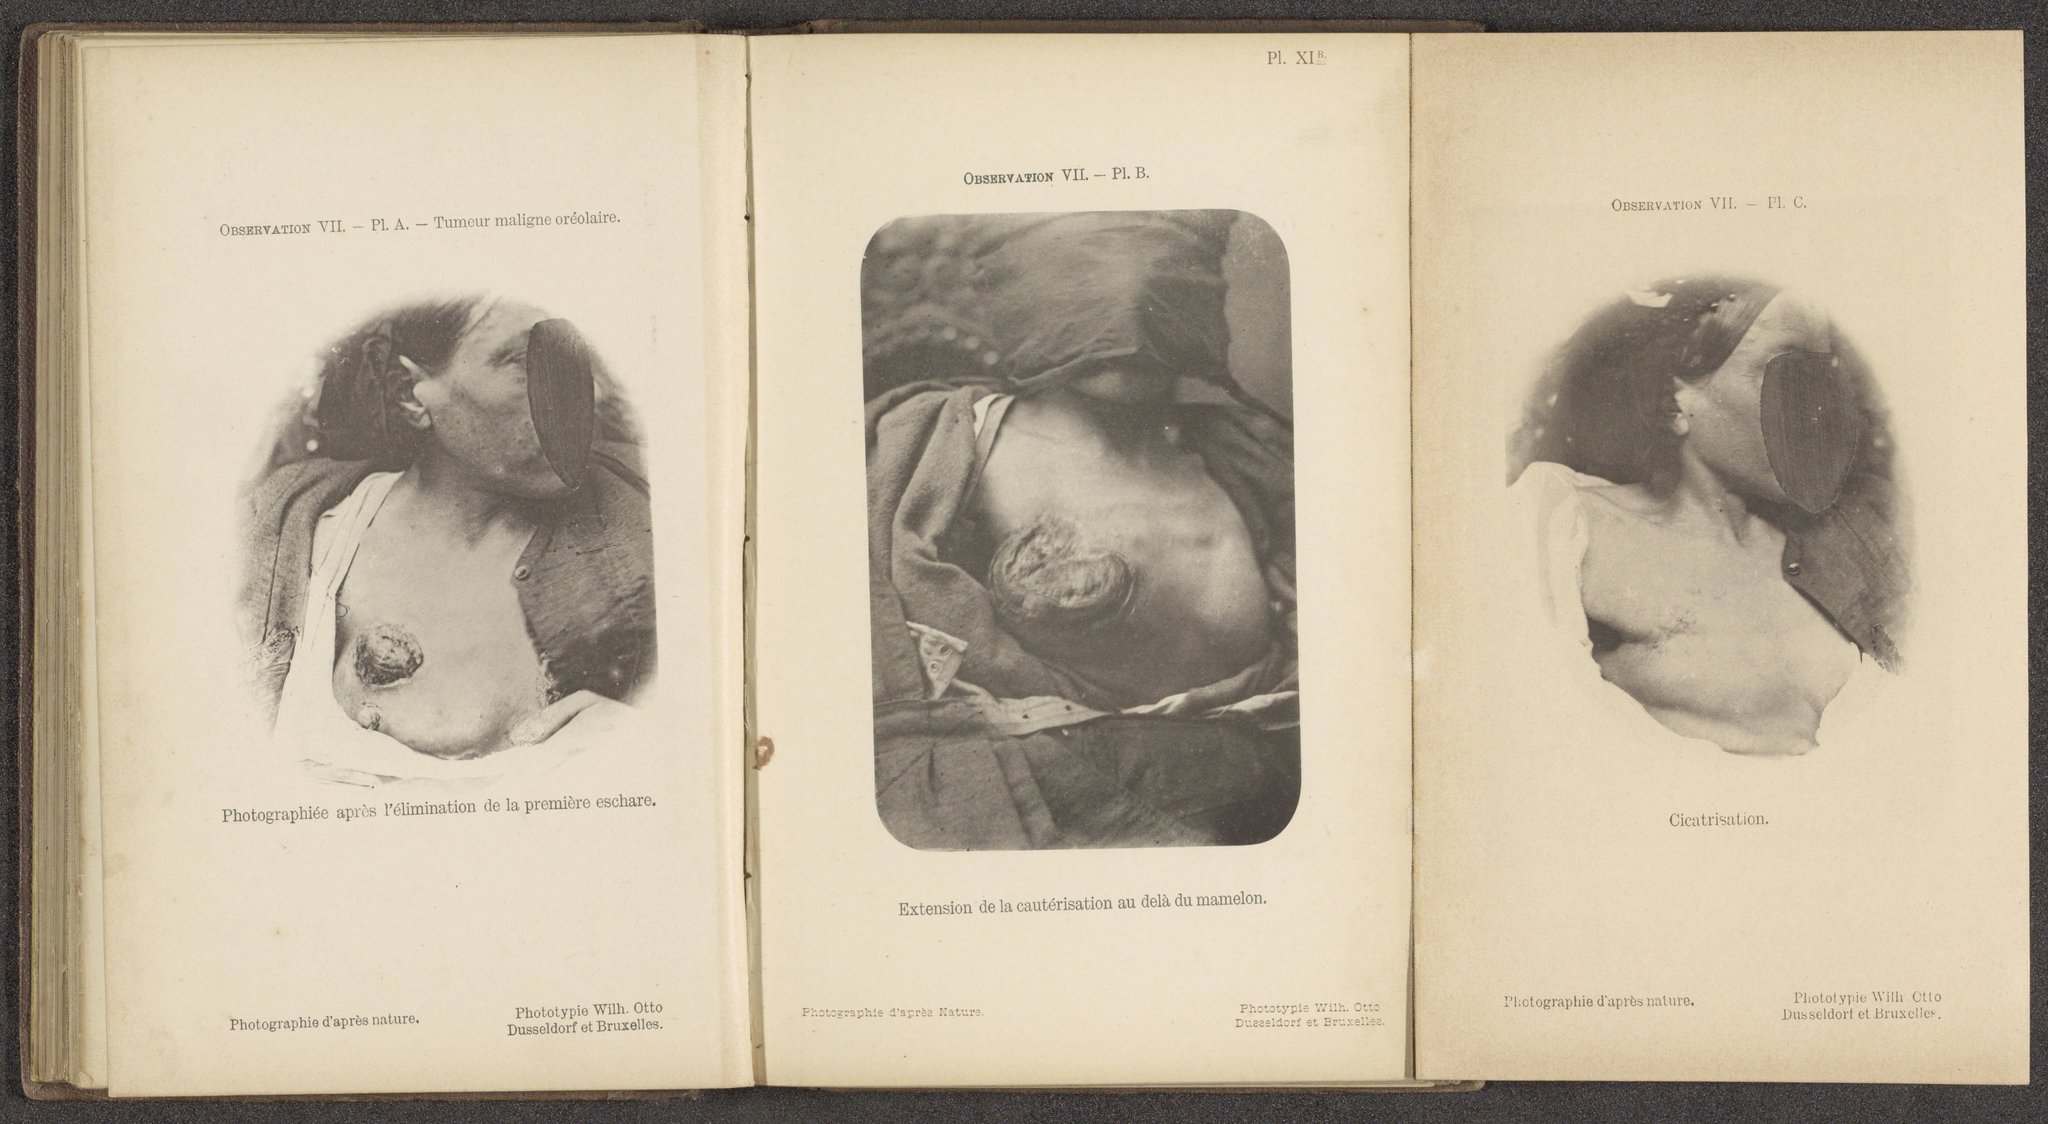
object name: page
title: Vrouw met een kwaadaardige tumor op haar tepelhof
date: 1874-1884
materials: paper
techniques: photograph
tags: tumours - aa - female human figure, infections and wounds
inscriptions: inscription: ‘Observation VII. - Pl. A. - Tumeur maligne oréolaire. (...)’